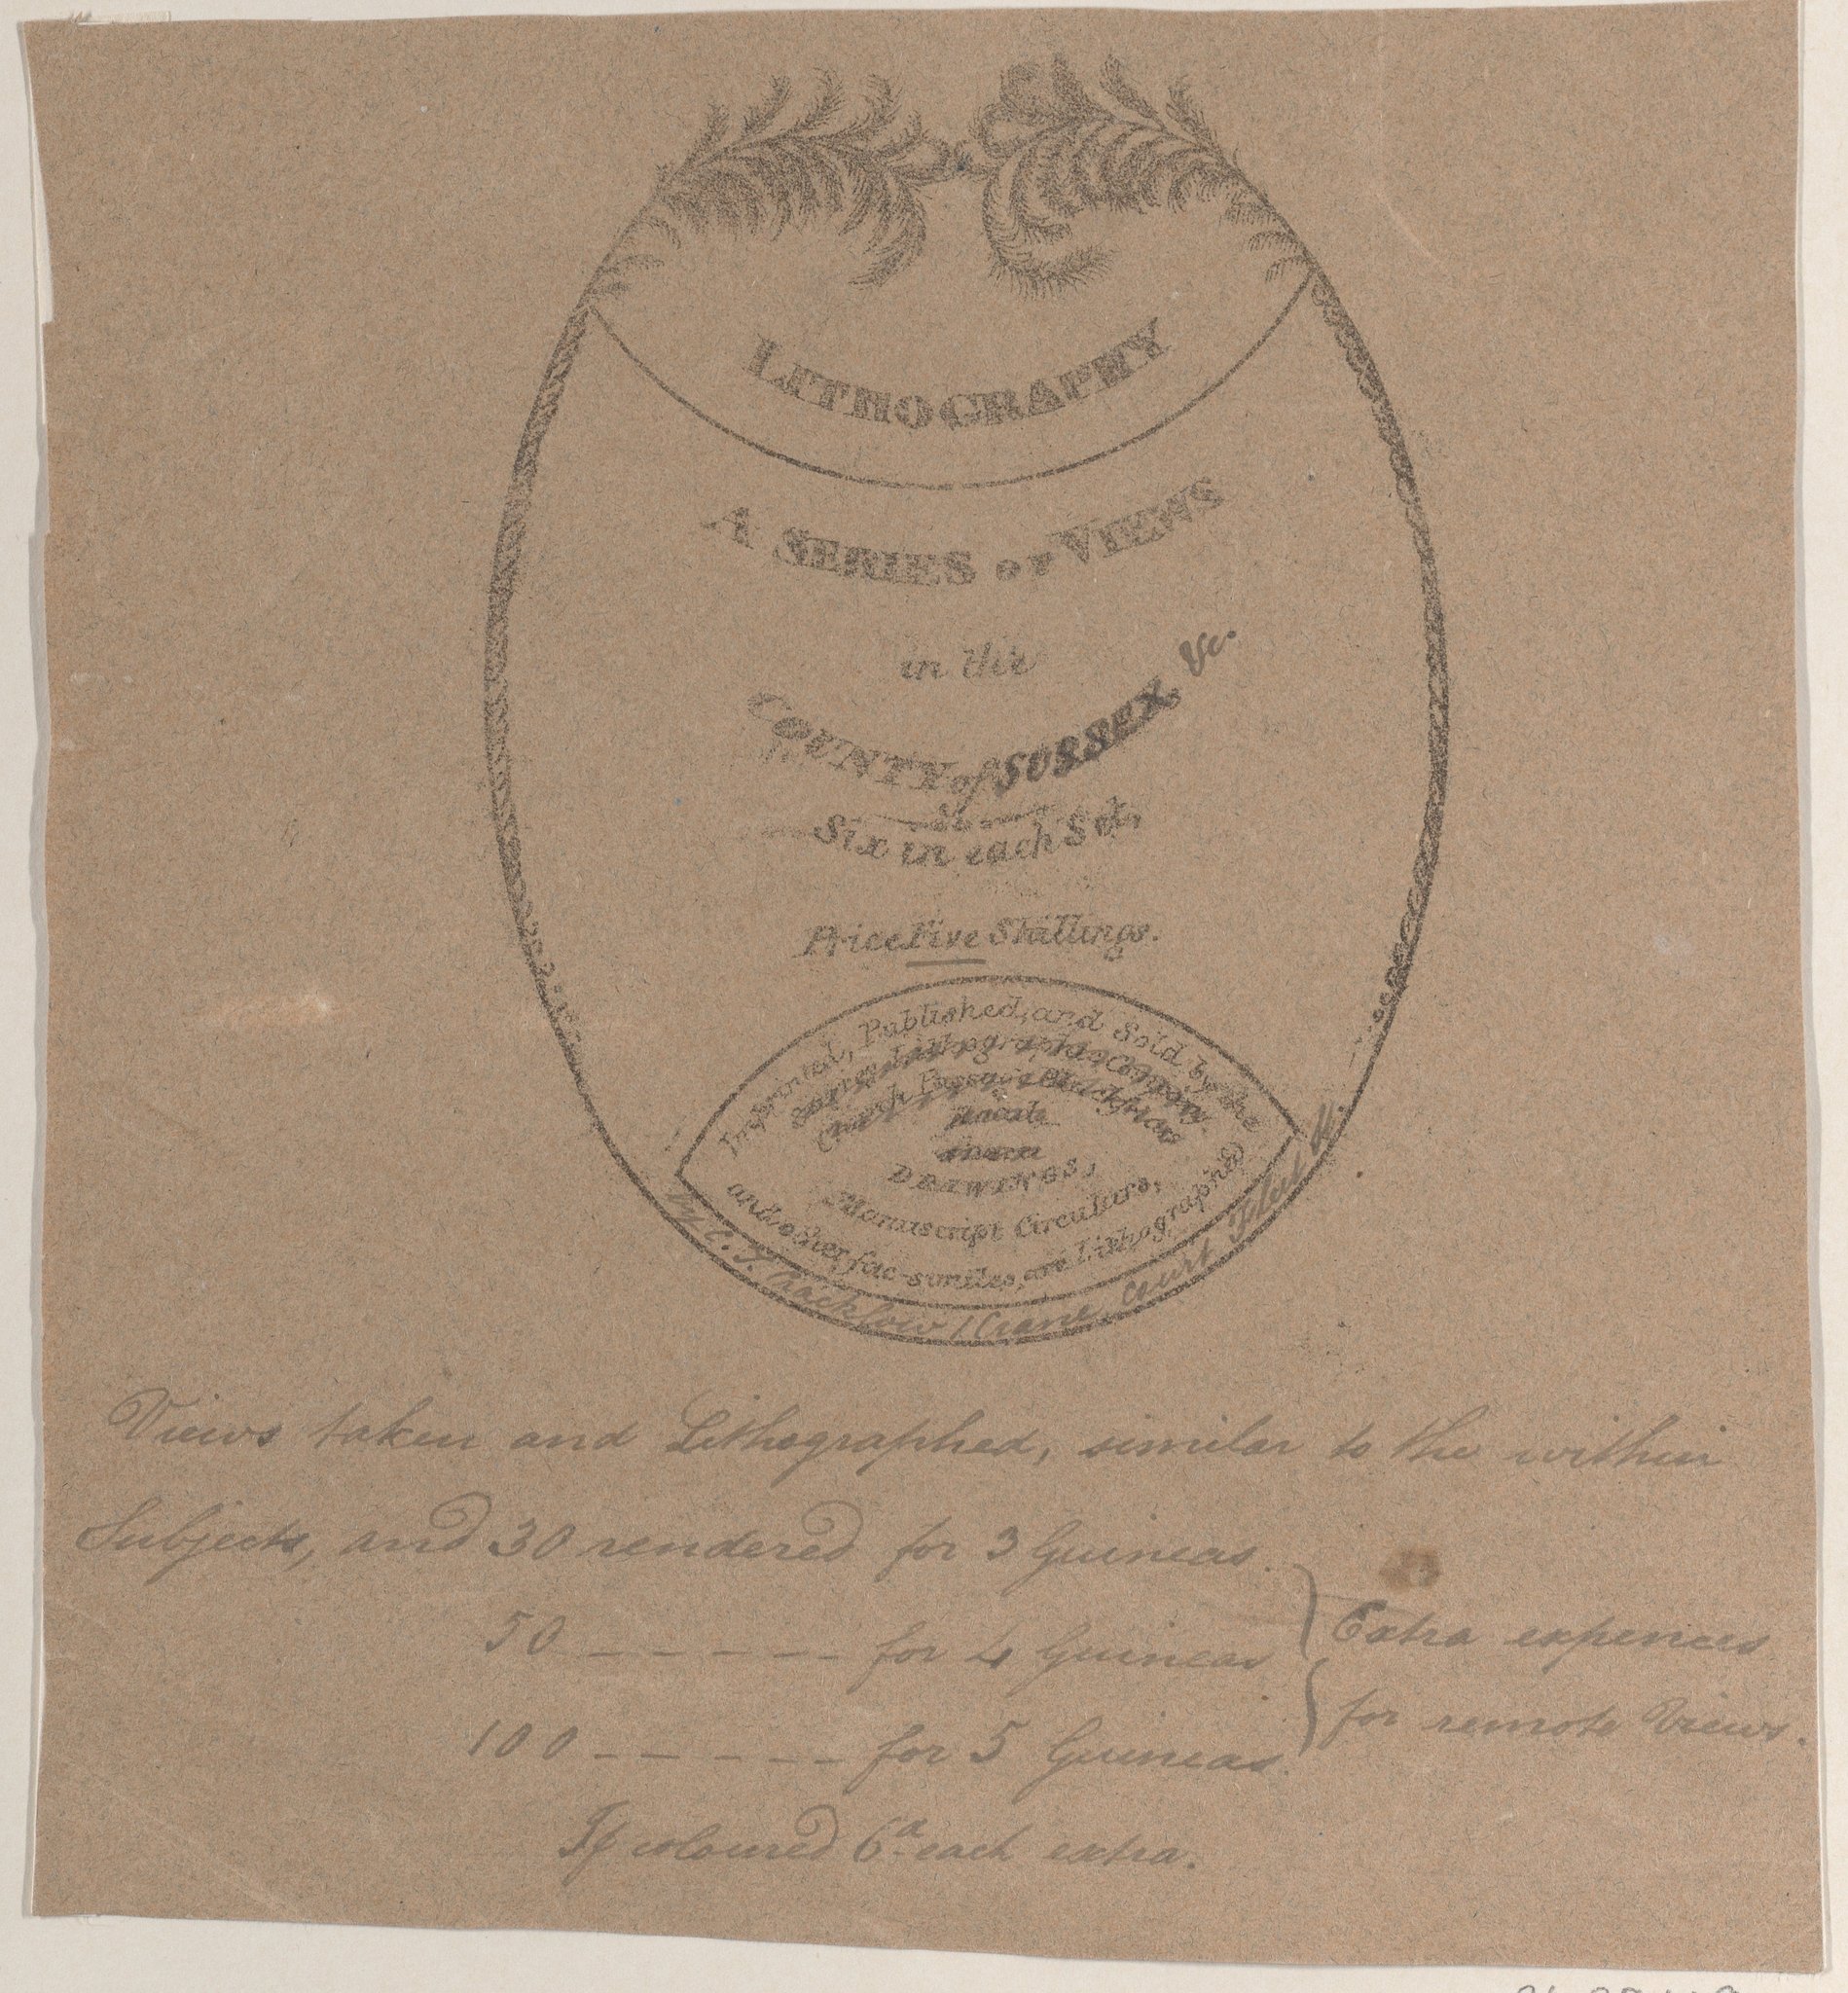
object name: print, trade card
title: Trade card for Surrey Lithographic Company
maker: anonymous, british, 19th century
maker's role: artist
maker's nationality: british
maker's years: 1800-1900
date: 1801-1900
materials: paper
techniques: lithography